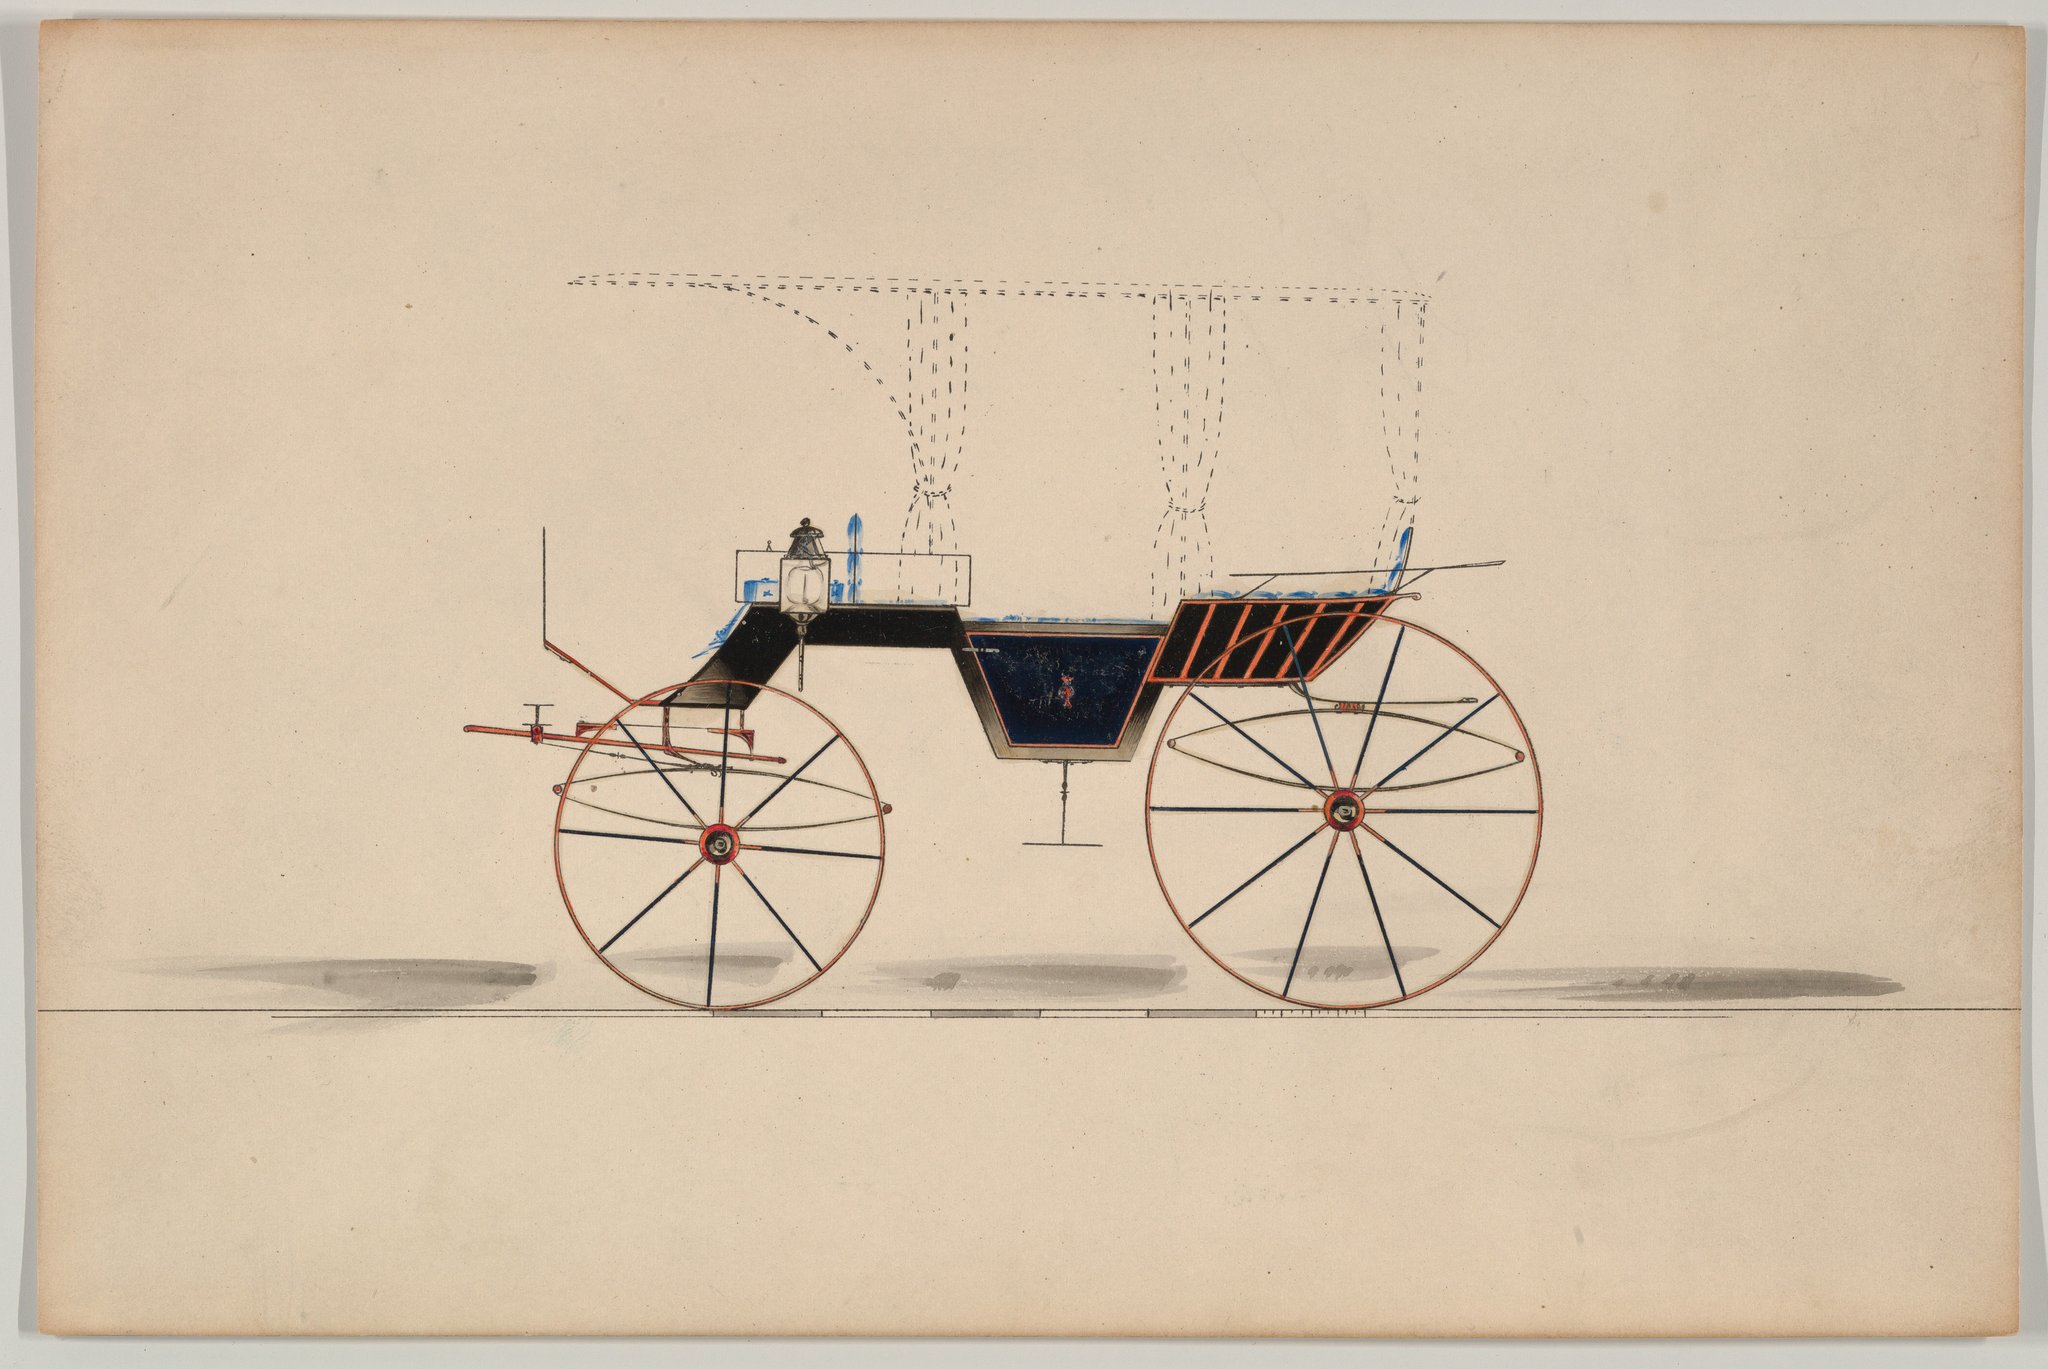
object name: drawing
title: Design for Sociable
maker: brewster & co.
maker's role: manufacturer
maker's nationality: american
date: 1850-1870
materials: gouache, gum arabic, ink, watercolor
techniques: pen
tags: carriages